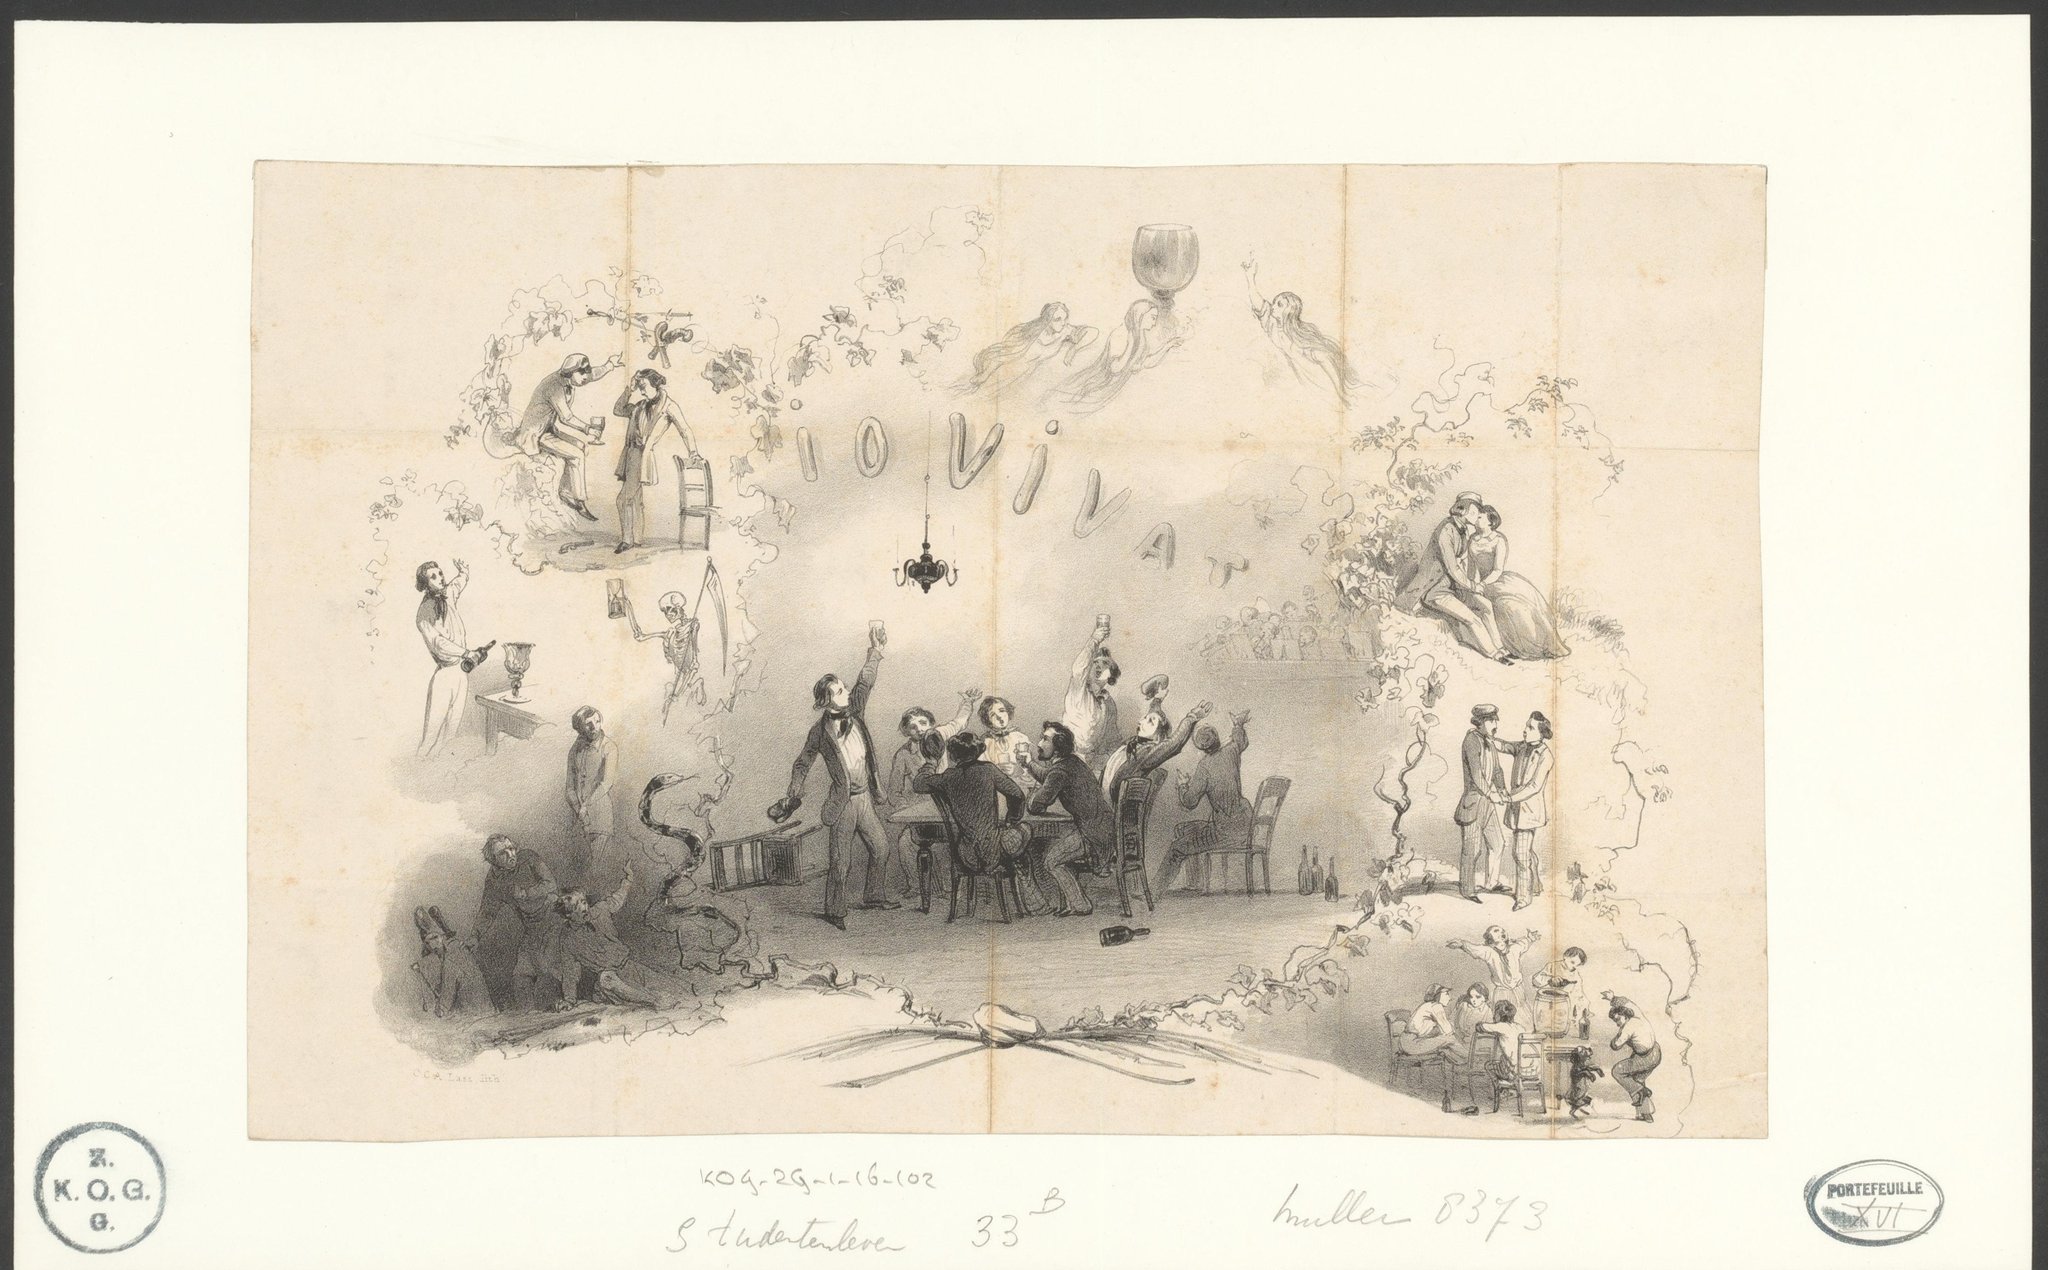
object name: print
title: Spotprent in Leidse studentenalmanak, 1849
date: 1849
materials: paper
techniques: lithograph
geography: the hague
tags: fraternity (students), vocal music, singing, drinking, student life, leiden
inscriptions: stamp, collector's mark: Lugt 1641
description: Een zingend studentengezelschap onder het opschrift 'Io Vivat', omringd door kleine voorstellingen uit het studentenleven. Onderwerpsrubrieken binnen de Atlas Zeden en Gewoonten: Onderwijs en Wetenschappen, Studentenleven.